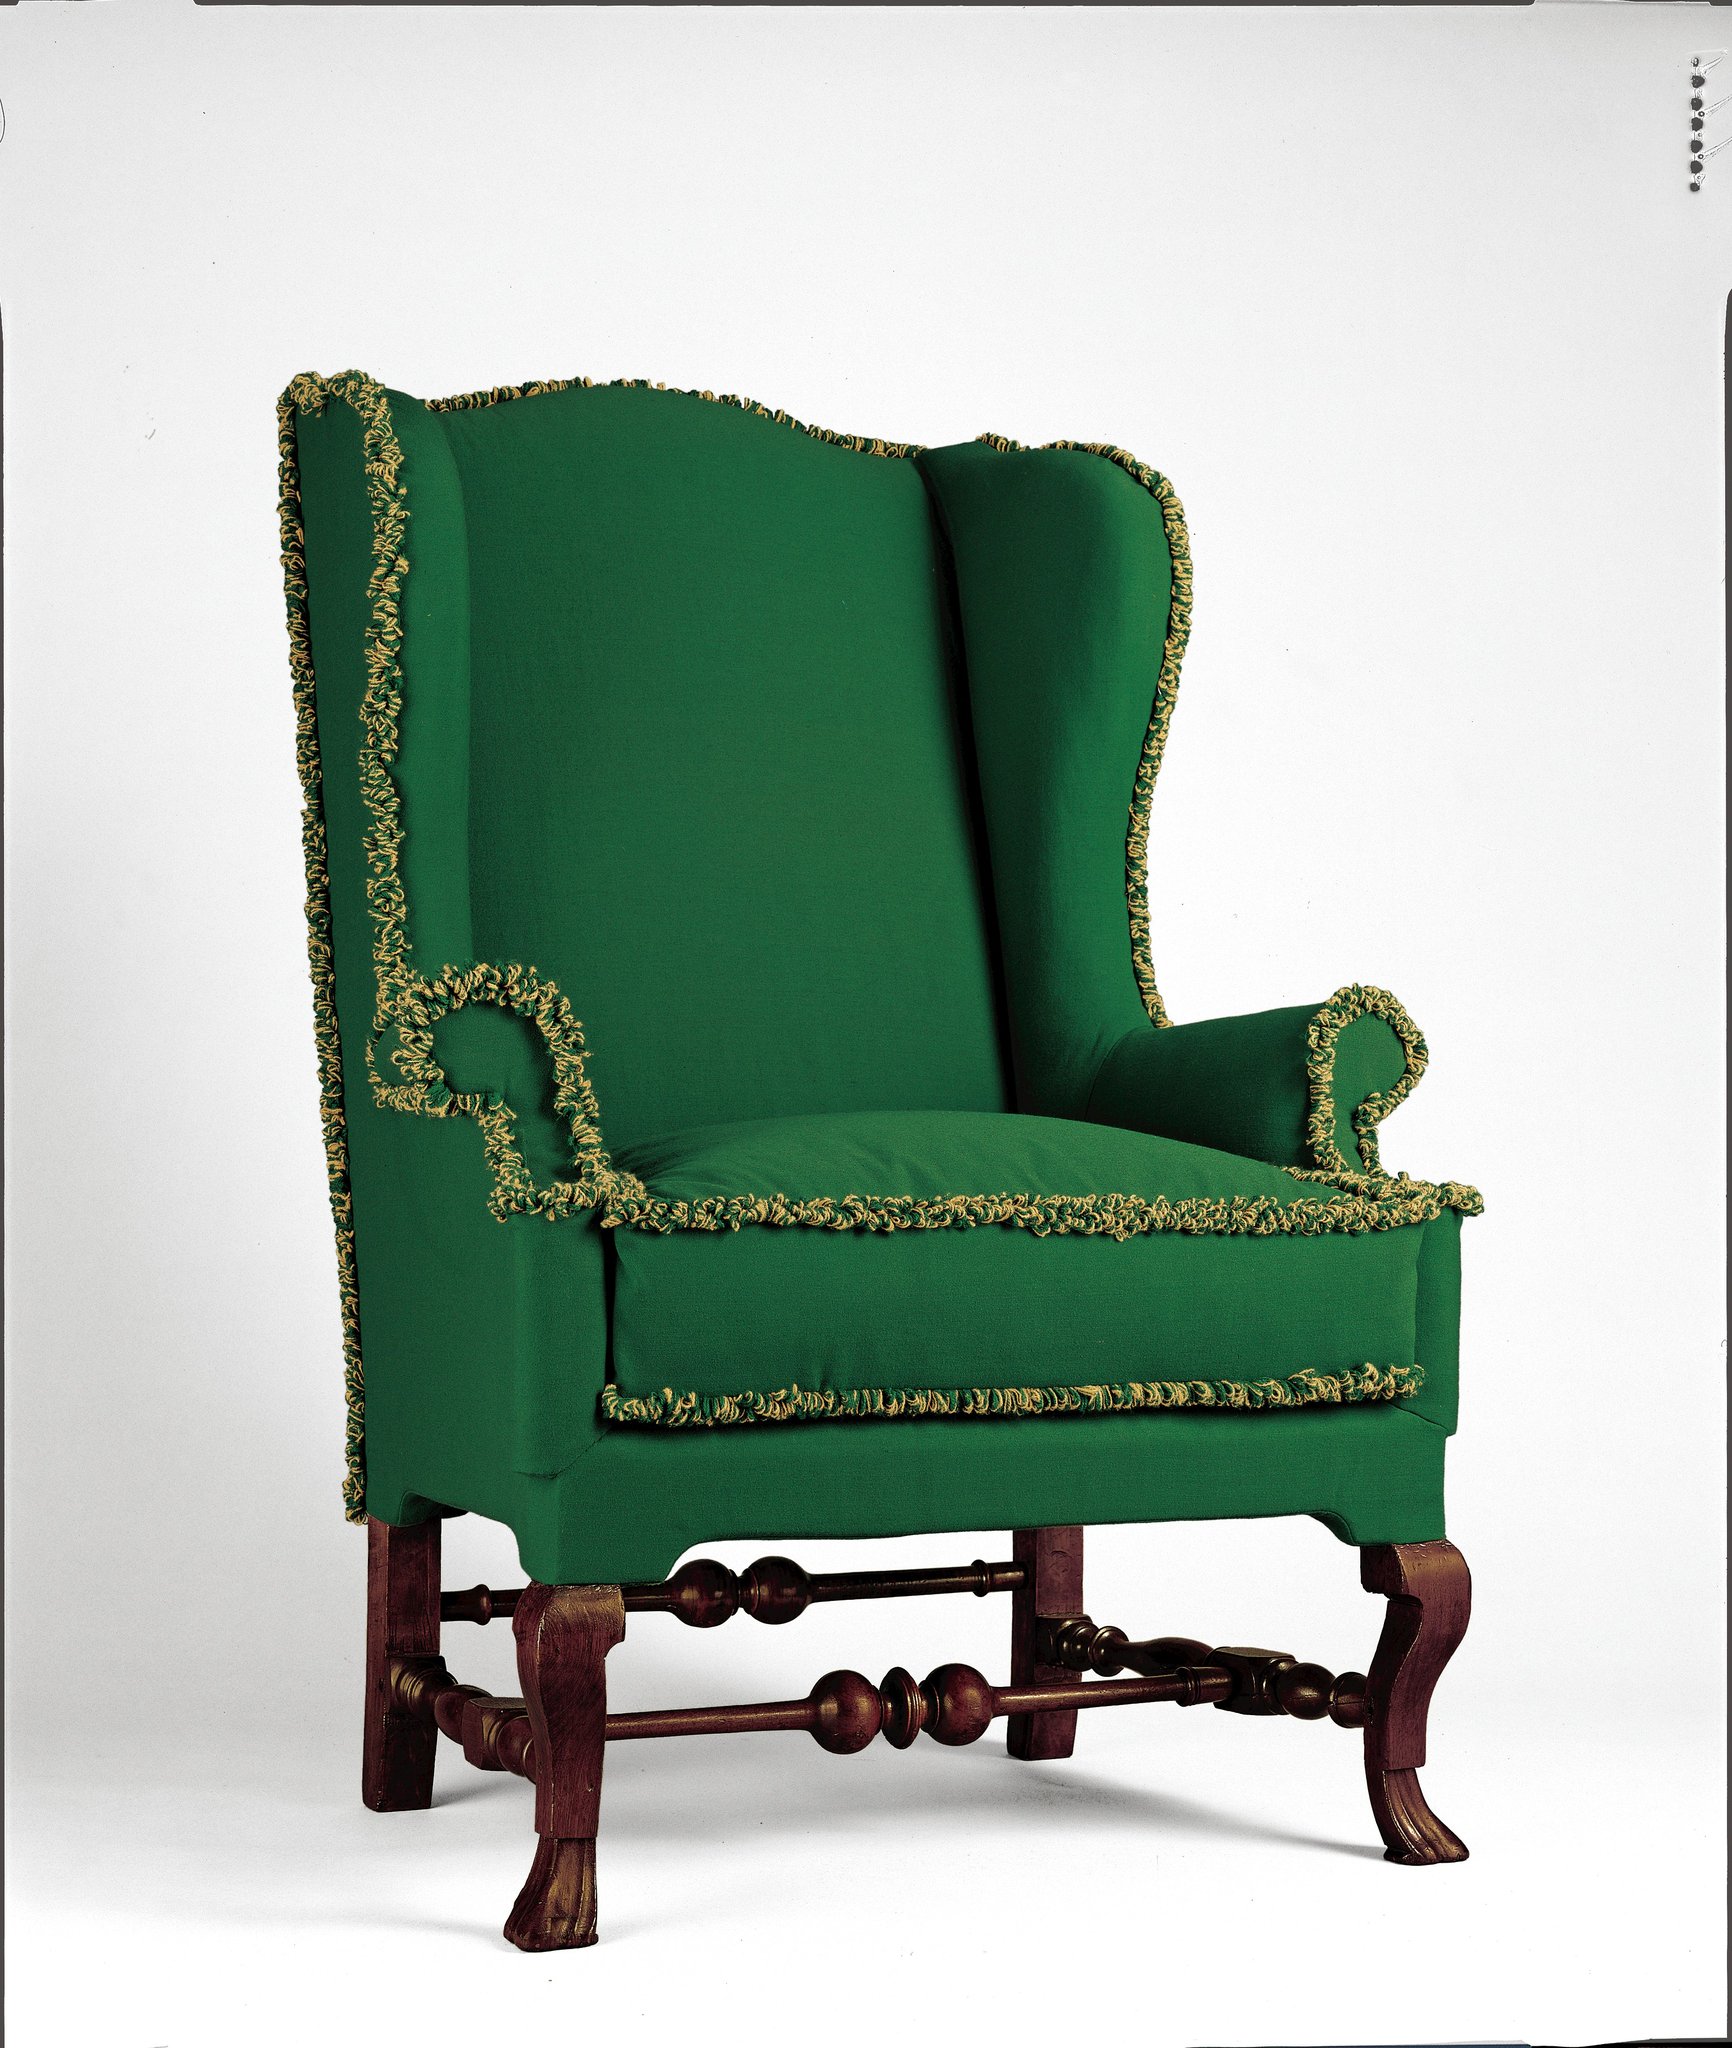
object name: easy chair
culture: american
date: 1730-1740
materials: wood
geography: united states